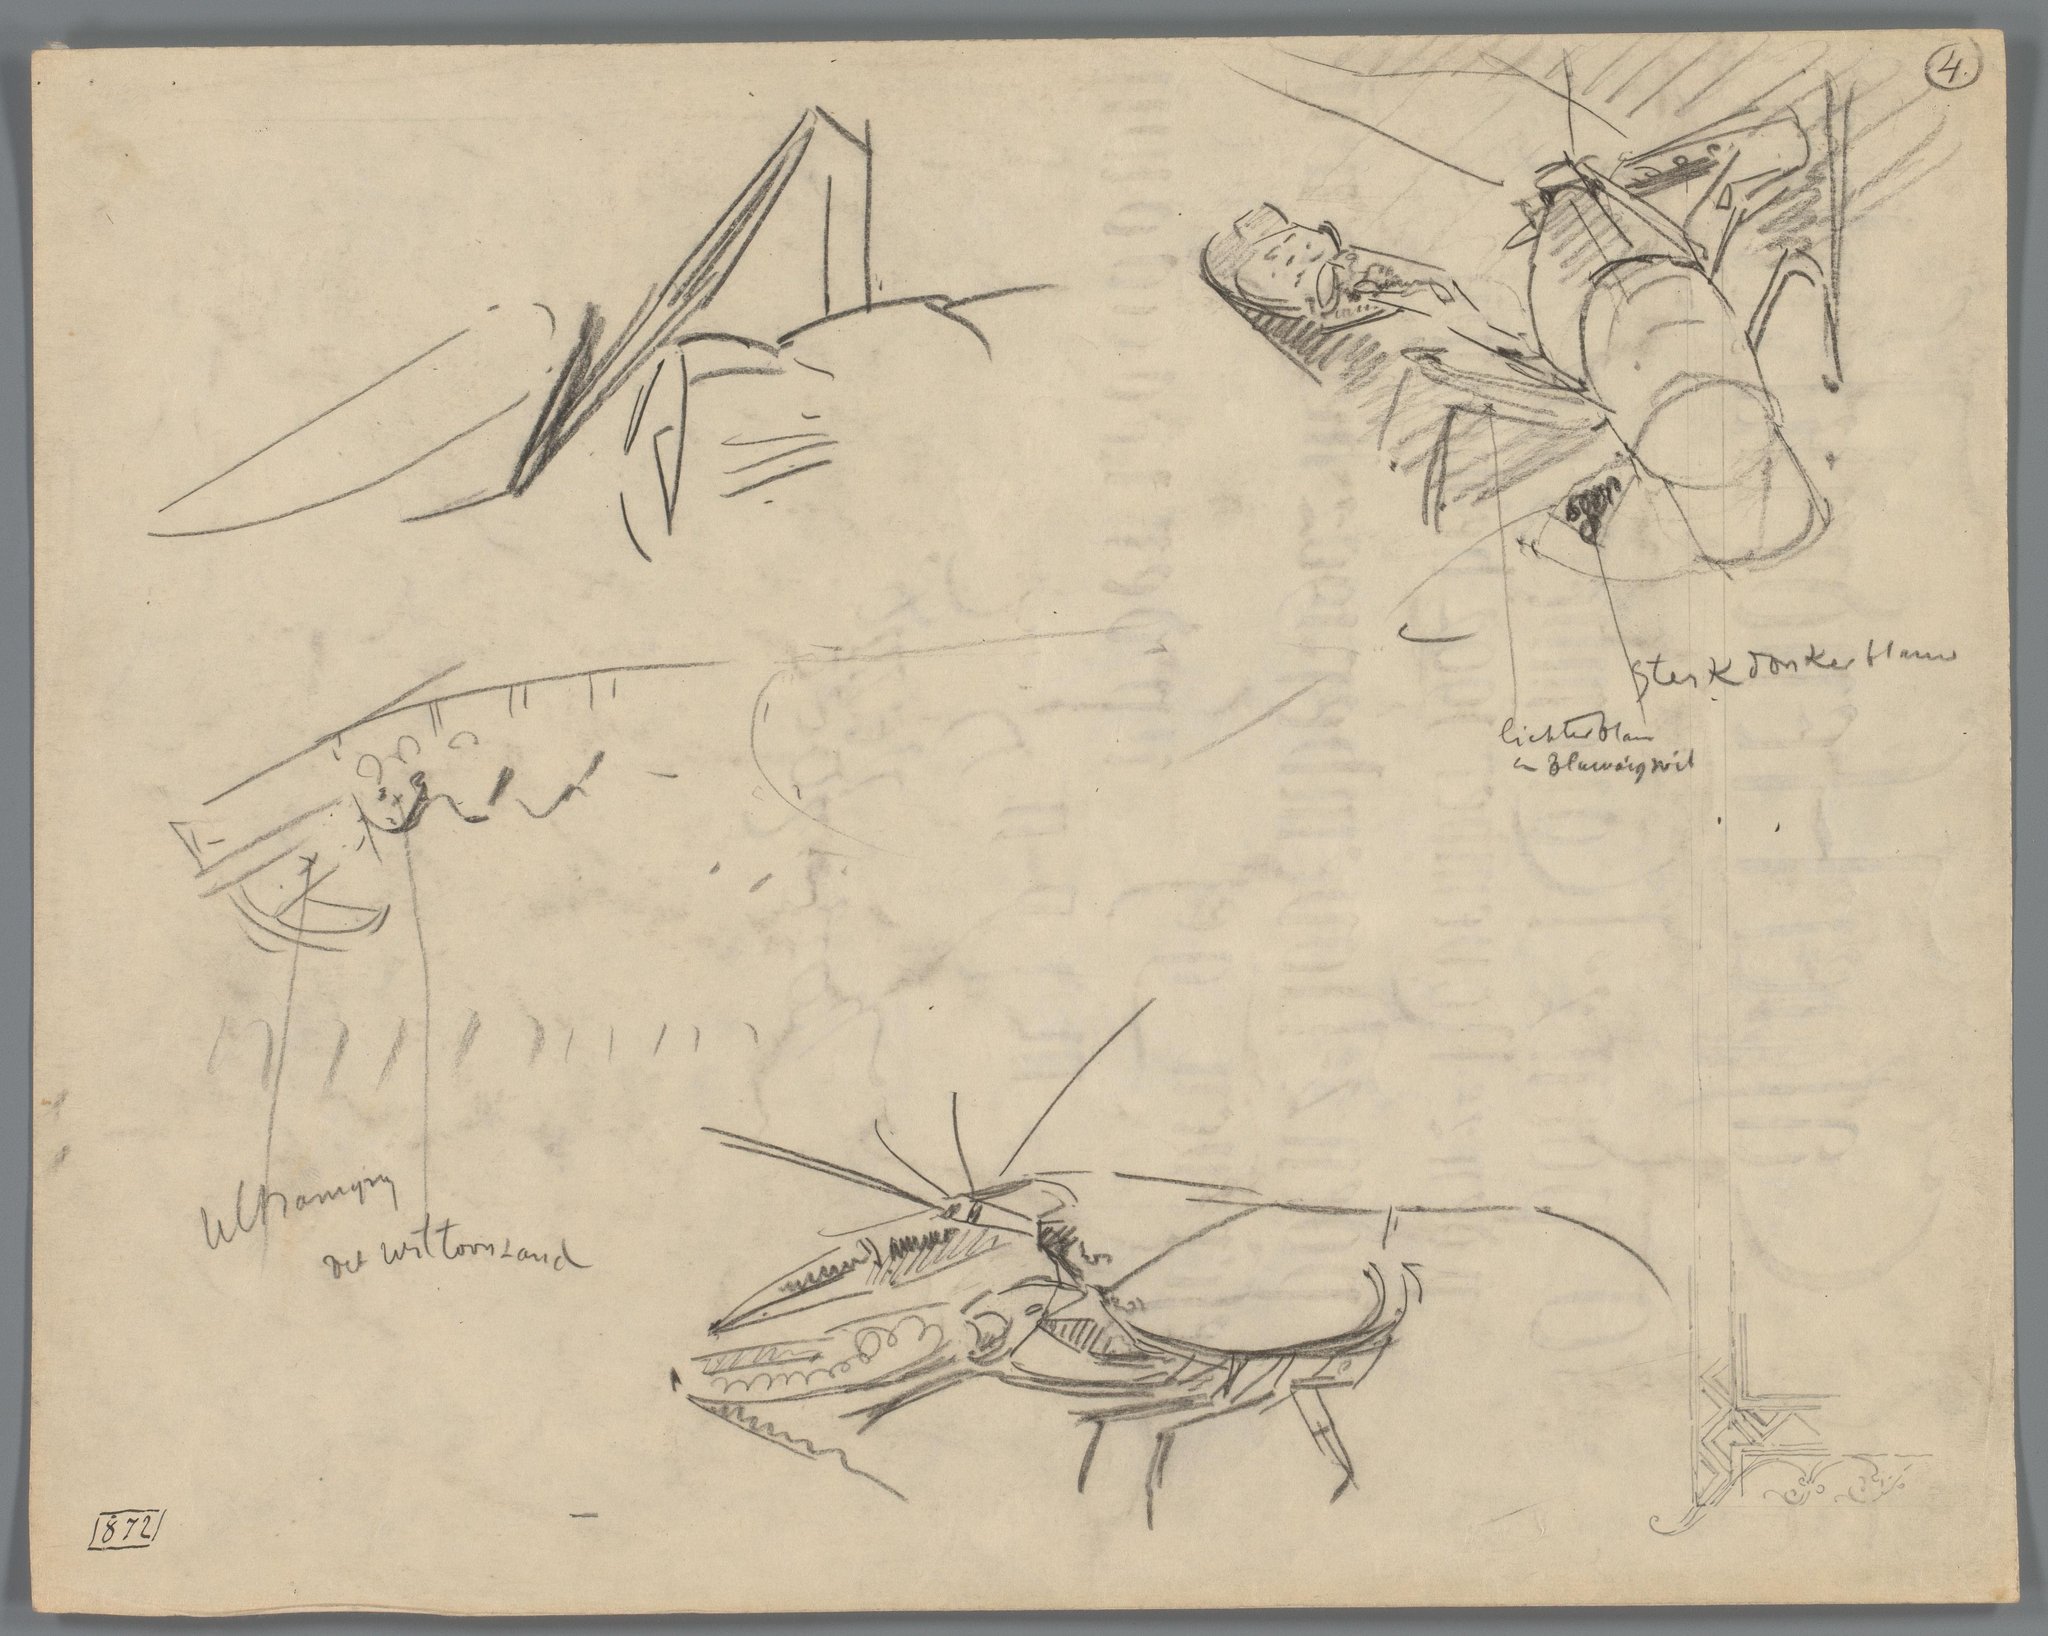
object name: drawing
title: Studies van kreeften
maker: gerrit willem dijsselhof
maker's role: designer, draughtsman, print maker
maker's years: 1866-1924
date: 1876-1924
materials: chalk, paper, pencil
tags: crustaceans: lobster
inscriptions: number: ‘872’, number: ‘4’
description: Tevens rechtsonder een studie van een ornament.